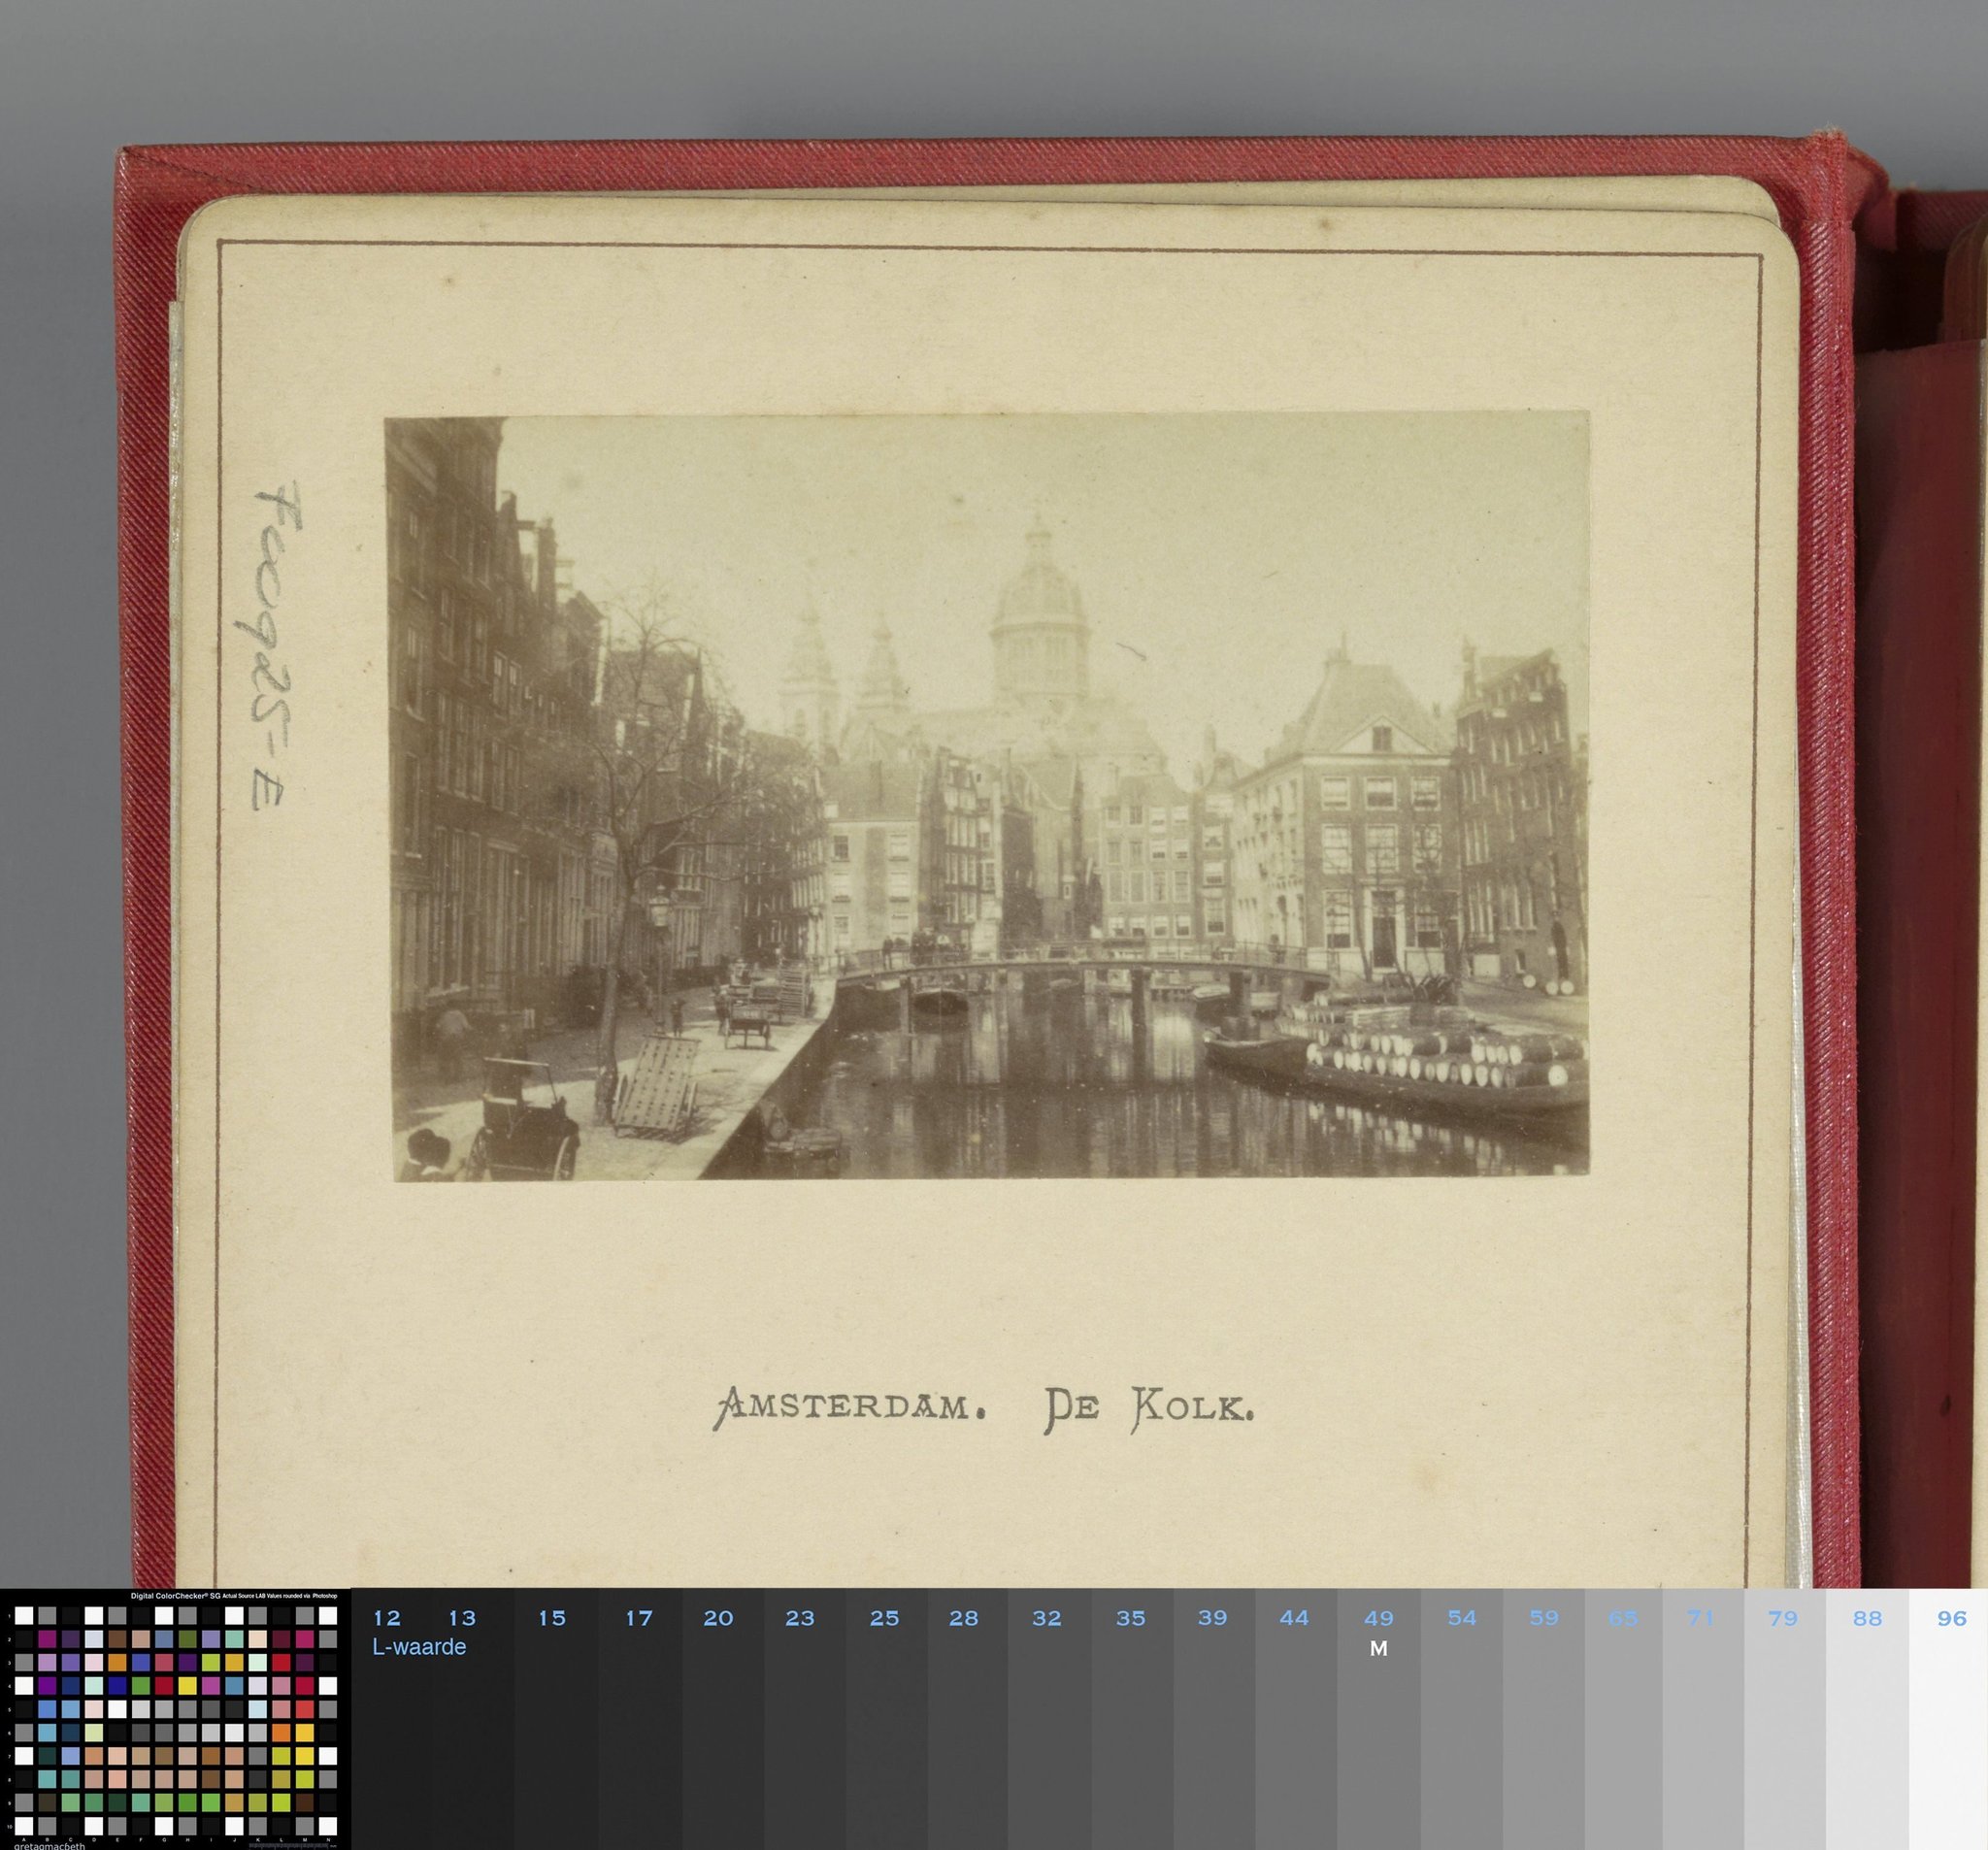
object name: photograph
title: Oudezijds Voorburgwal gezien naar de Oudezijds Kolk en de St. Nicolaaskerk in Amsterdam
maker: andries jager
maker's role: publisher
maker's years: 1825-1905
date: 1884-1900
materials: cardboard, photographic support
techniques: albumen print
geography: amsterdam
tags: canal, church (exterior)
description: Onderdeel van Fotoalbum met opnames van steden in Noord- en Zuid-Holland en Utrecht.